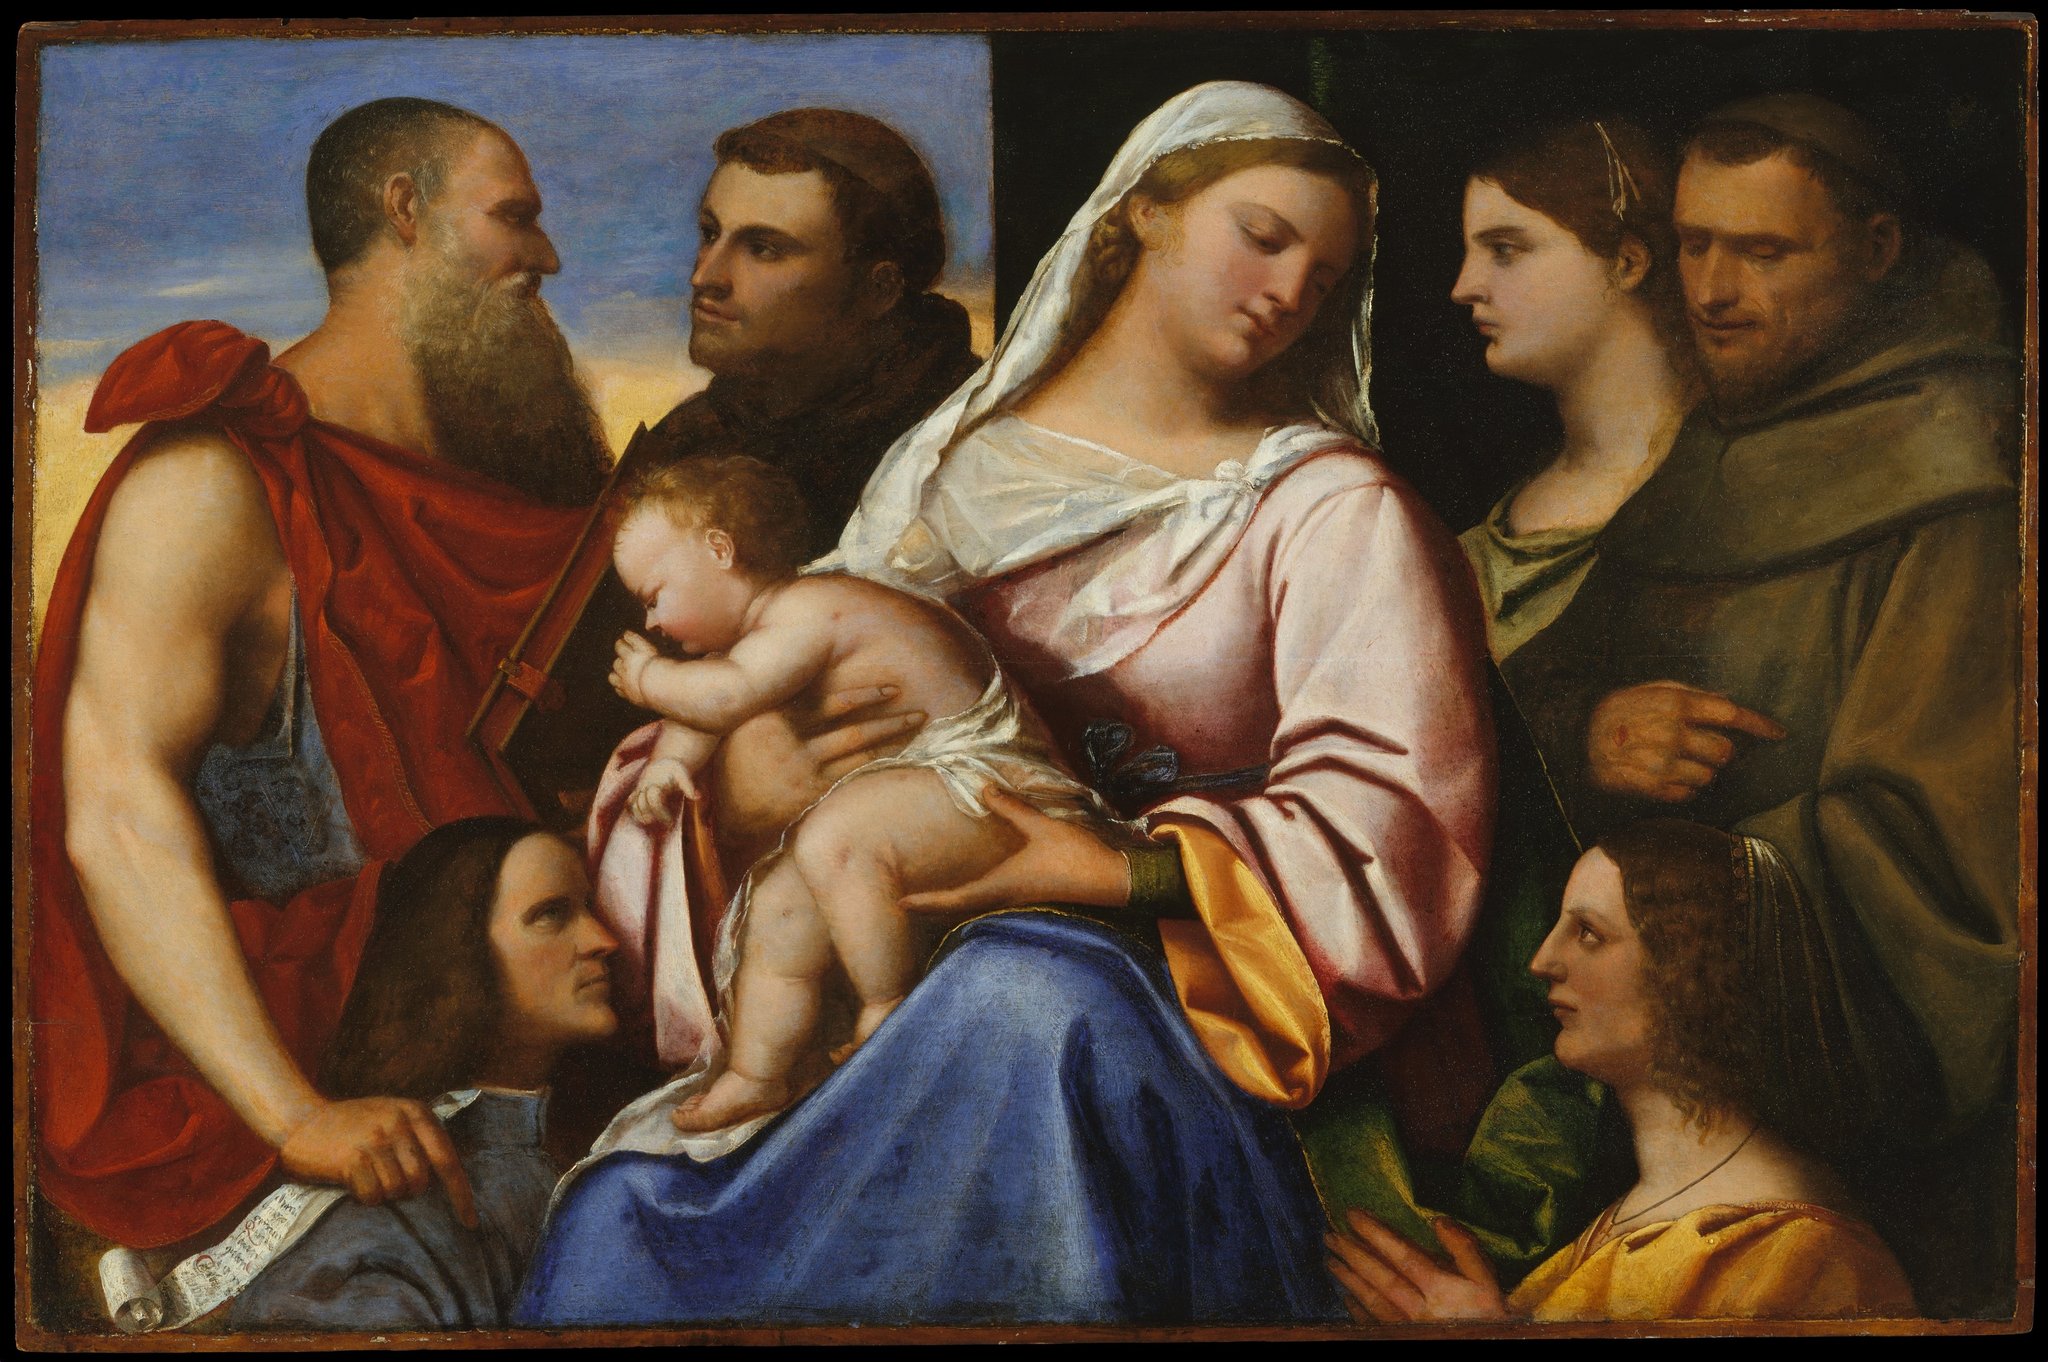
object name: painting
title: Madonna and Child with Saints and Donors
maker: sebastiano del piombo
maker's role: artist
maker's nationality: italian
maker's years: 1485-1547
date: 1505-1547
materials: oil, wood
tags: men,women,madonna and child,monks,saints